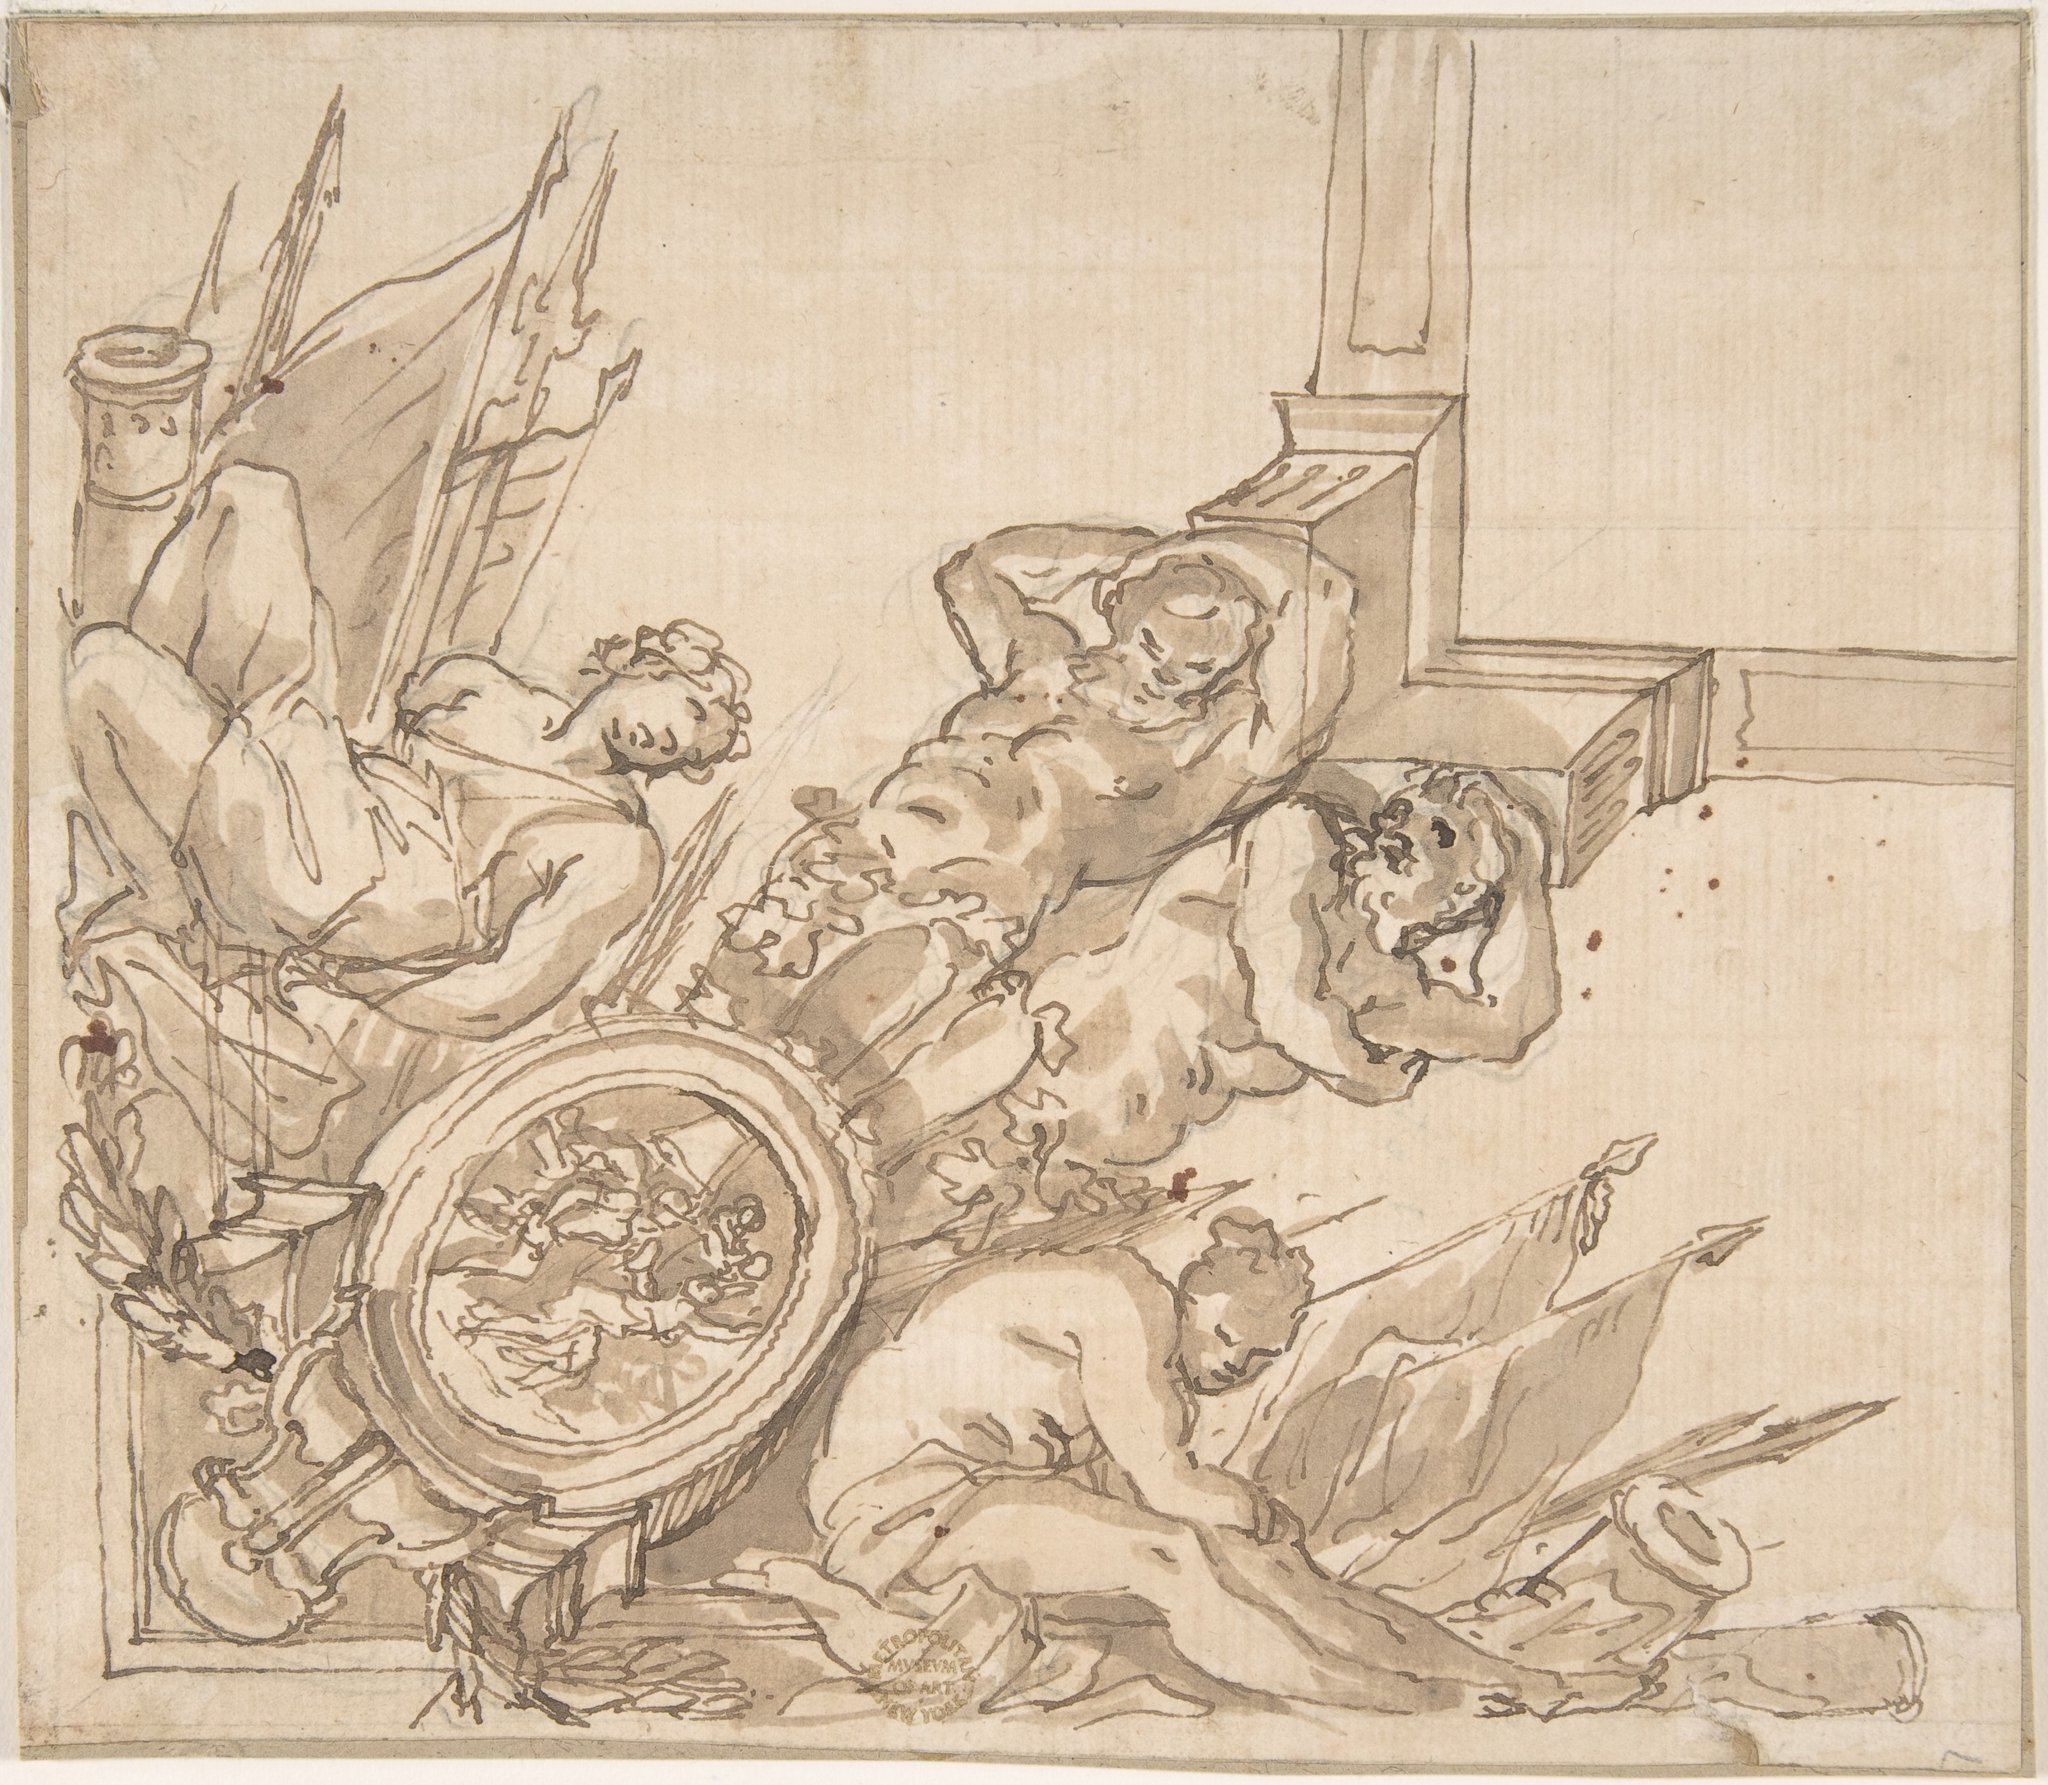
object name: drawing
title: Design for a Corner of a Ceiling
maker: anonymous, italian, roman-bolognese, 17th century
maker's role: artist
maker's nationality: italian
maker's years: 1600-1700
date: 1601-1700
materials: chalk, ink, paper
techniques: brush, pen, wash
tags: men,women